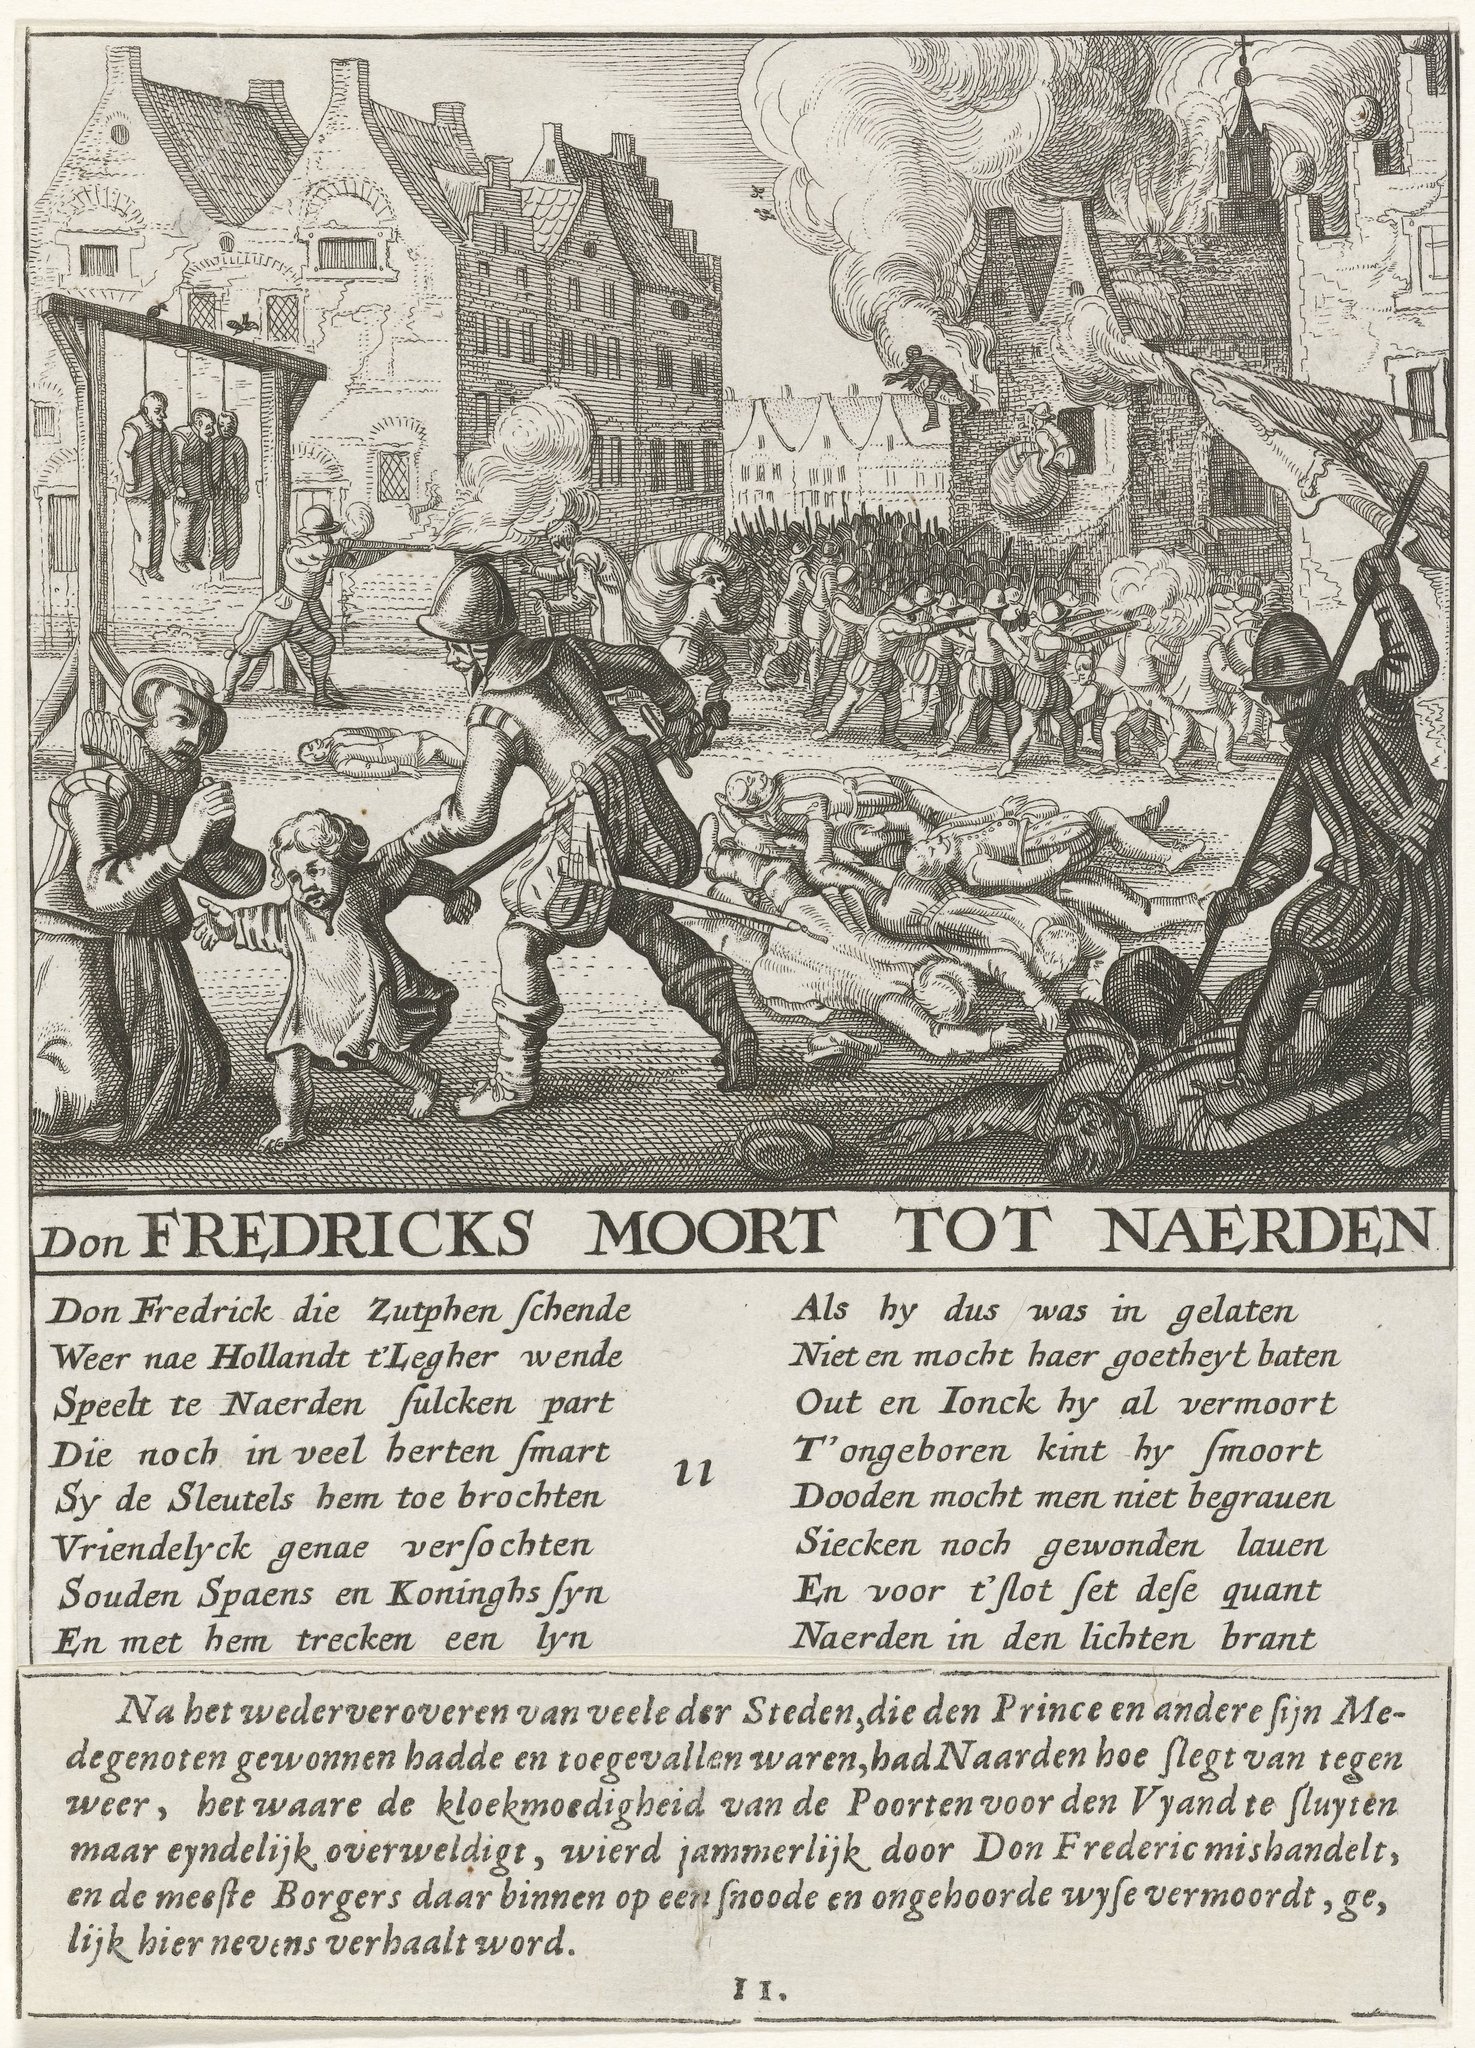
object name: print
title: Moordpartij te Naarden, 1572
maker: Anonymous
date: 1618-1624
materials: paper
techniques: etching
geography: northern netherlands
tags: massacre ~ war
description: Illustratie voor een (onbekende) uitgave van het populaire en vaak herdrukte werk getiteld: De Spaensche Tiranye gheschiet in Nederlant, waarschijnlijk voor het eerst ca. 1620 verschenen. Zie ook Hollstein (Dutch), vol. XXXVIII (Claes Jansz. Visscher II), p. 165, nr. 425 en een andere versie van dit werk uitgegeven in 1621 te Amsterdam bij C.L. vander Plasse, in de collectie van de Rijksmuseum Research Library, signatuur 327 K 30.